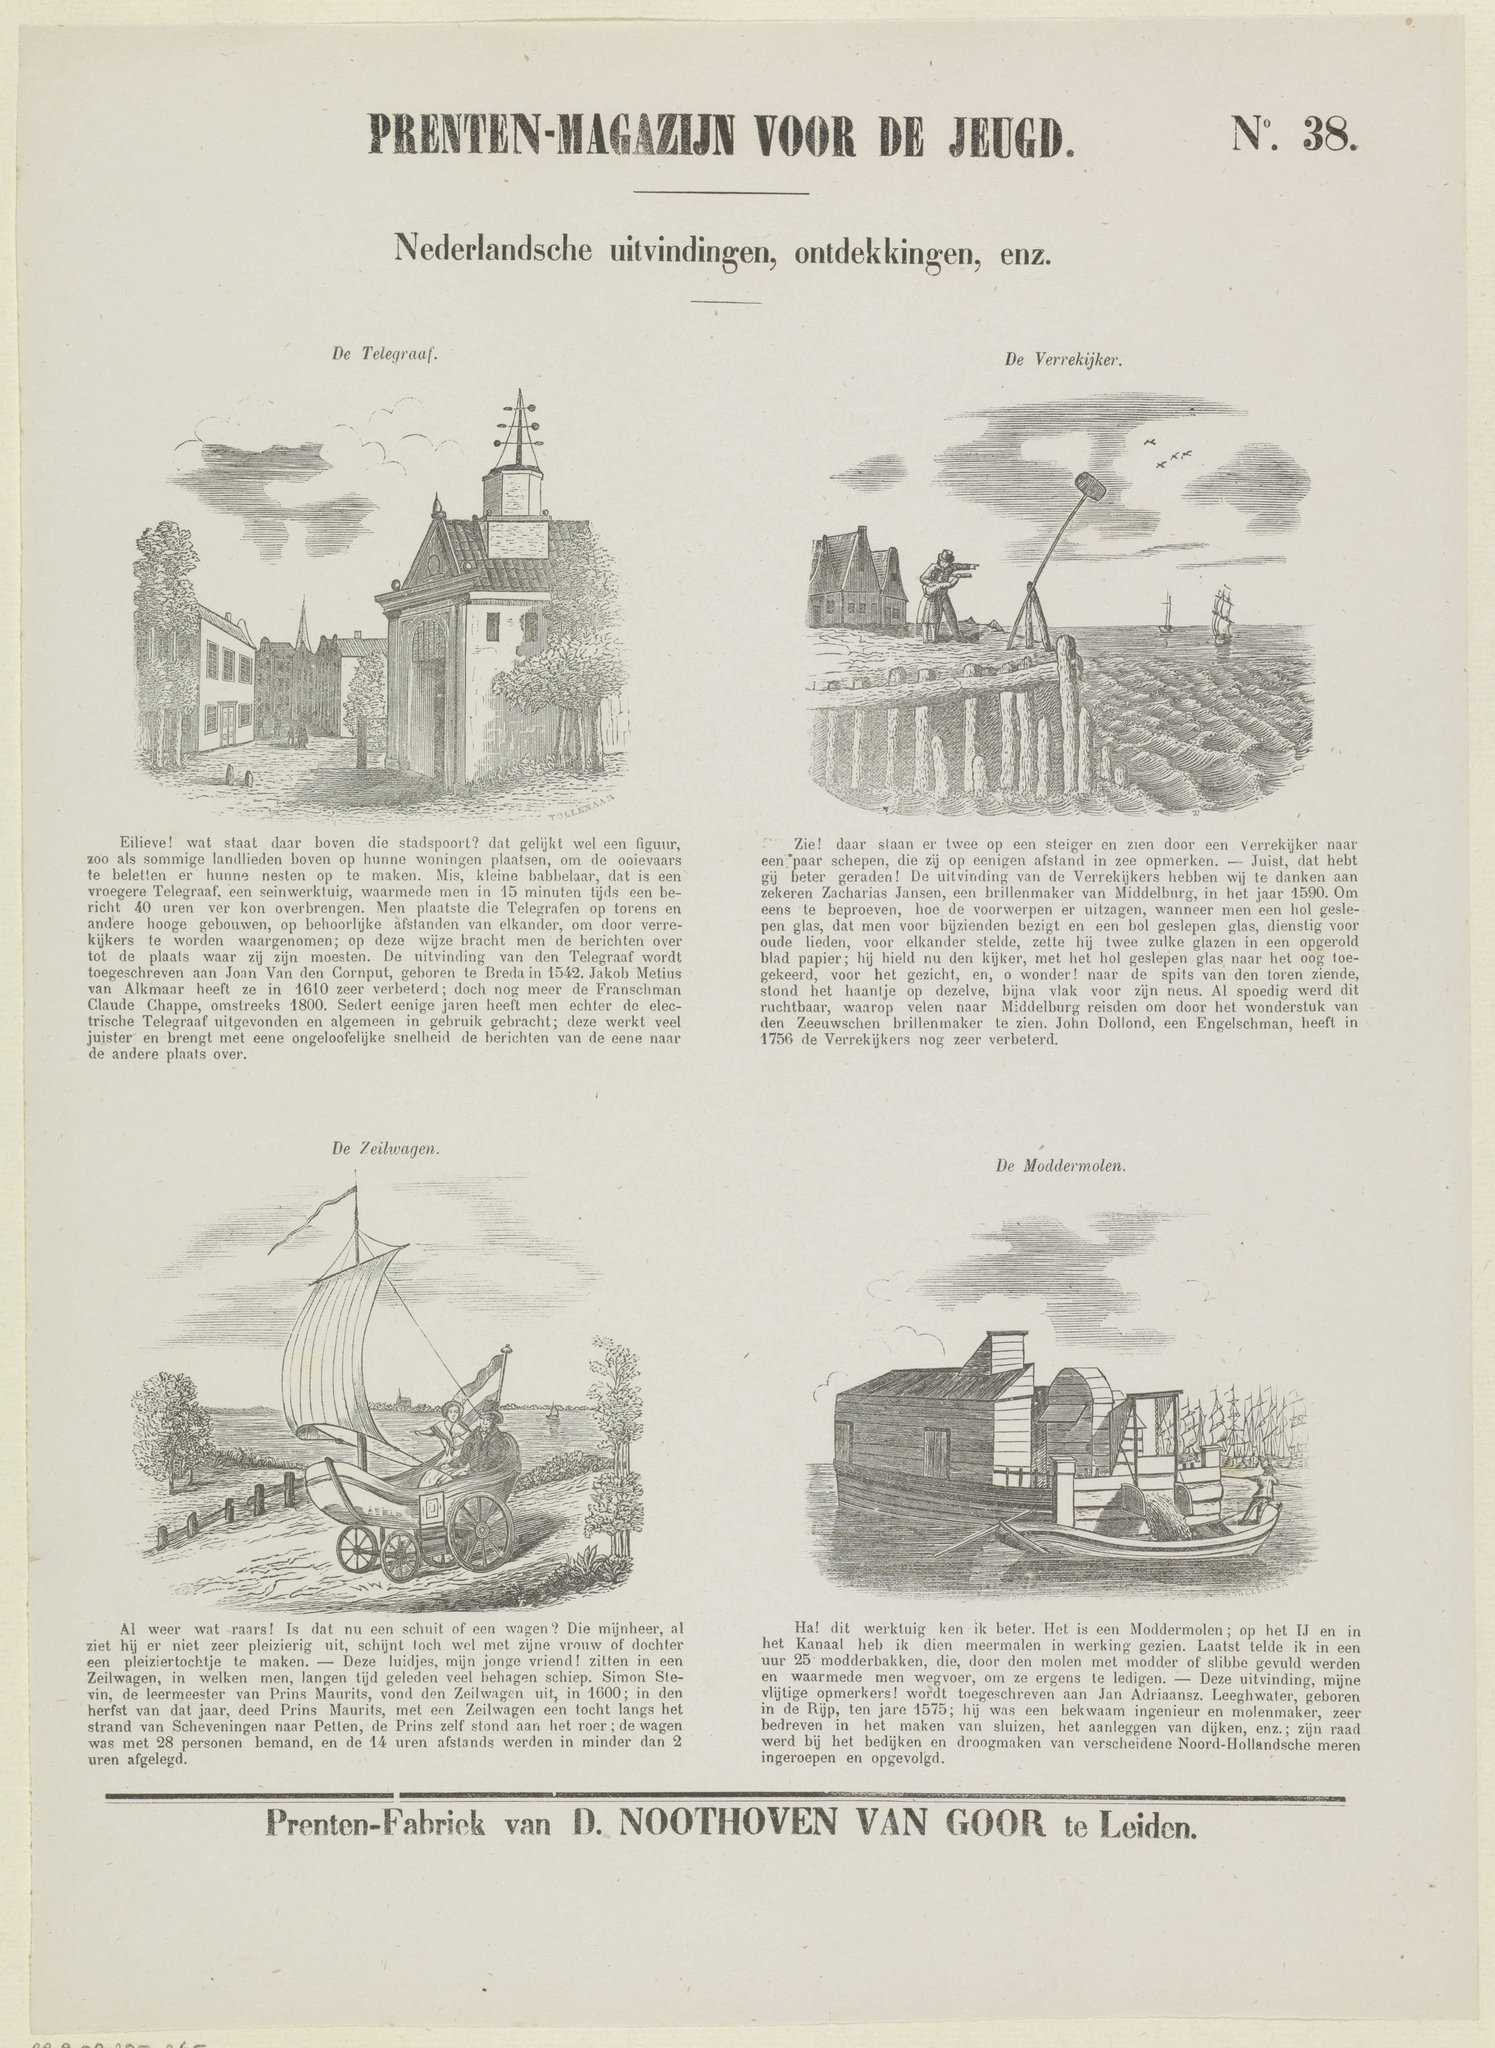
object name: popular print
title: Nederlandsche uitvindingen, ontdekkingen, enz.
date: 1850-1881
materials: paper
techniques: letterpress printing, engraving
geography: netherlands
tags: (morse) telegraph, sailing-ship, sailing-boat (+ traffic on land), dredge, dredging machine, invention, discovery ~ science and technology, binoculars, spy-glass, etc.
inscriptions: collector's mark: Lugt 2760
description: Blad met 4 voorstellingen van Nederlandse uitvindingen en ontdekkingen: de telegraaf, de verrekijker, de zeilwagen en de moddermolen. Boven elke voorstelling een titel en onder elke voorstelling een onderschrift. Genummerd rechtsboven: No. 38.